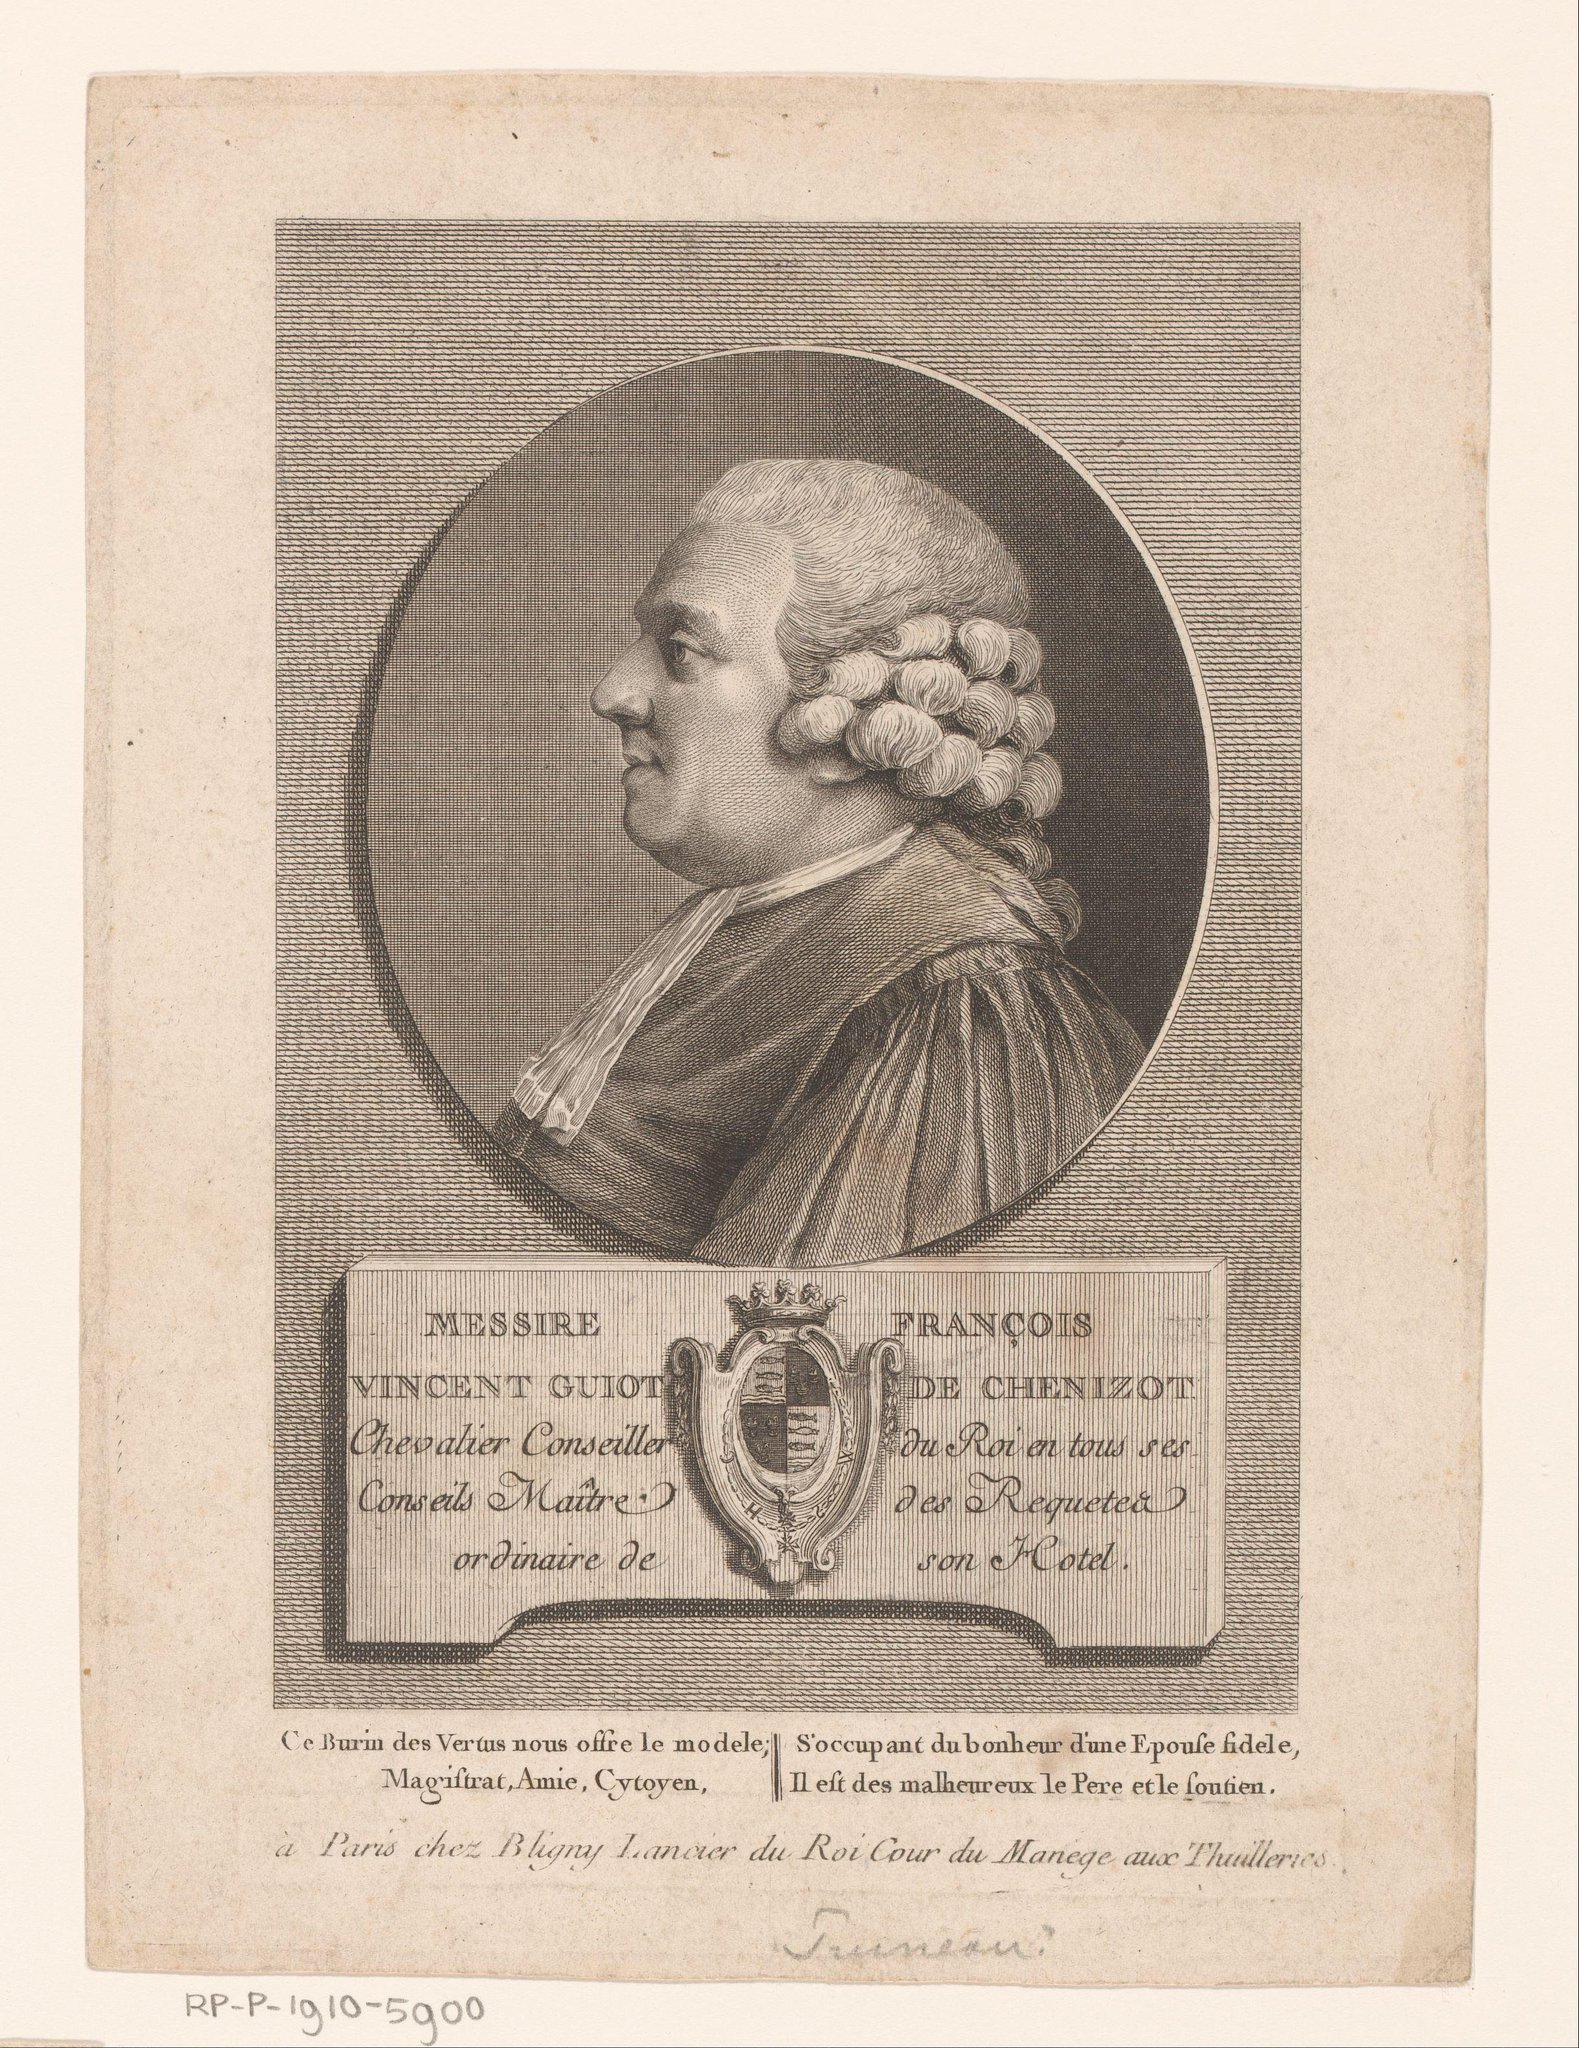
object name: print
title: Portret van François Vincent Guyot de Chenizot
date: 1761-1800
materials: paper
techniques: engraving, etching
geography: paris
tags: historical persons, politician, e.g. party leader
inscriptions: collector's mark: Lugt 2228